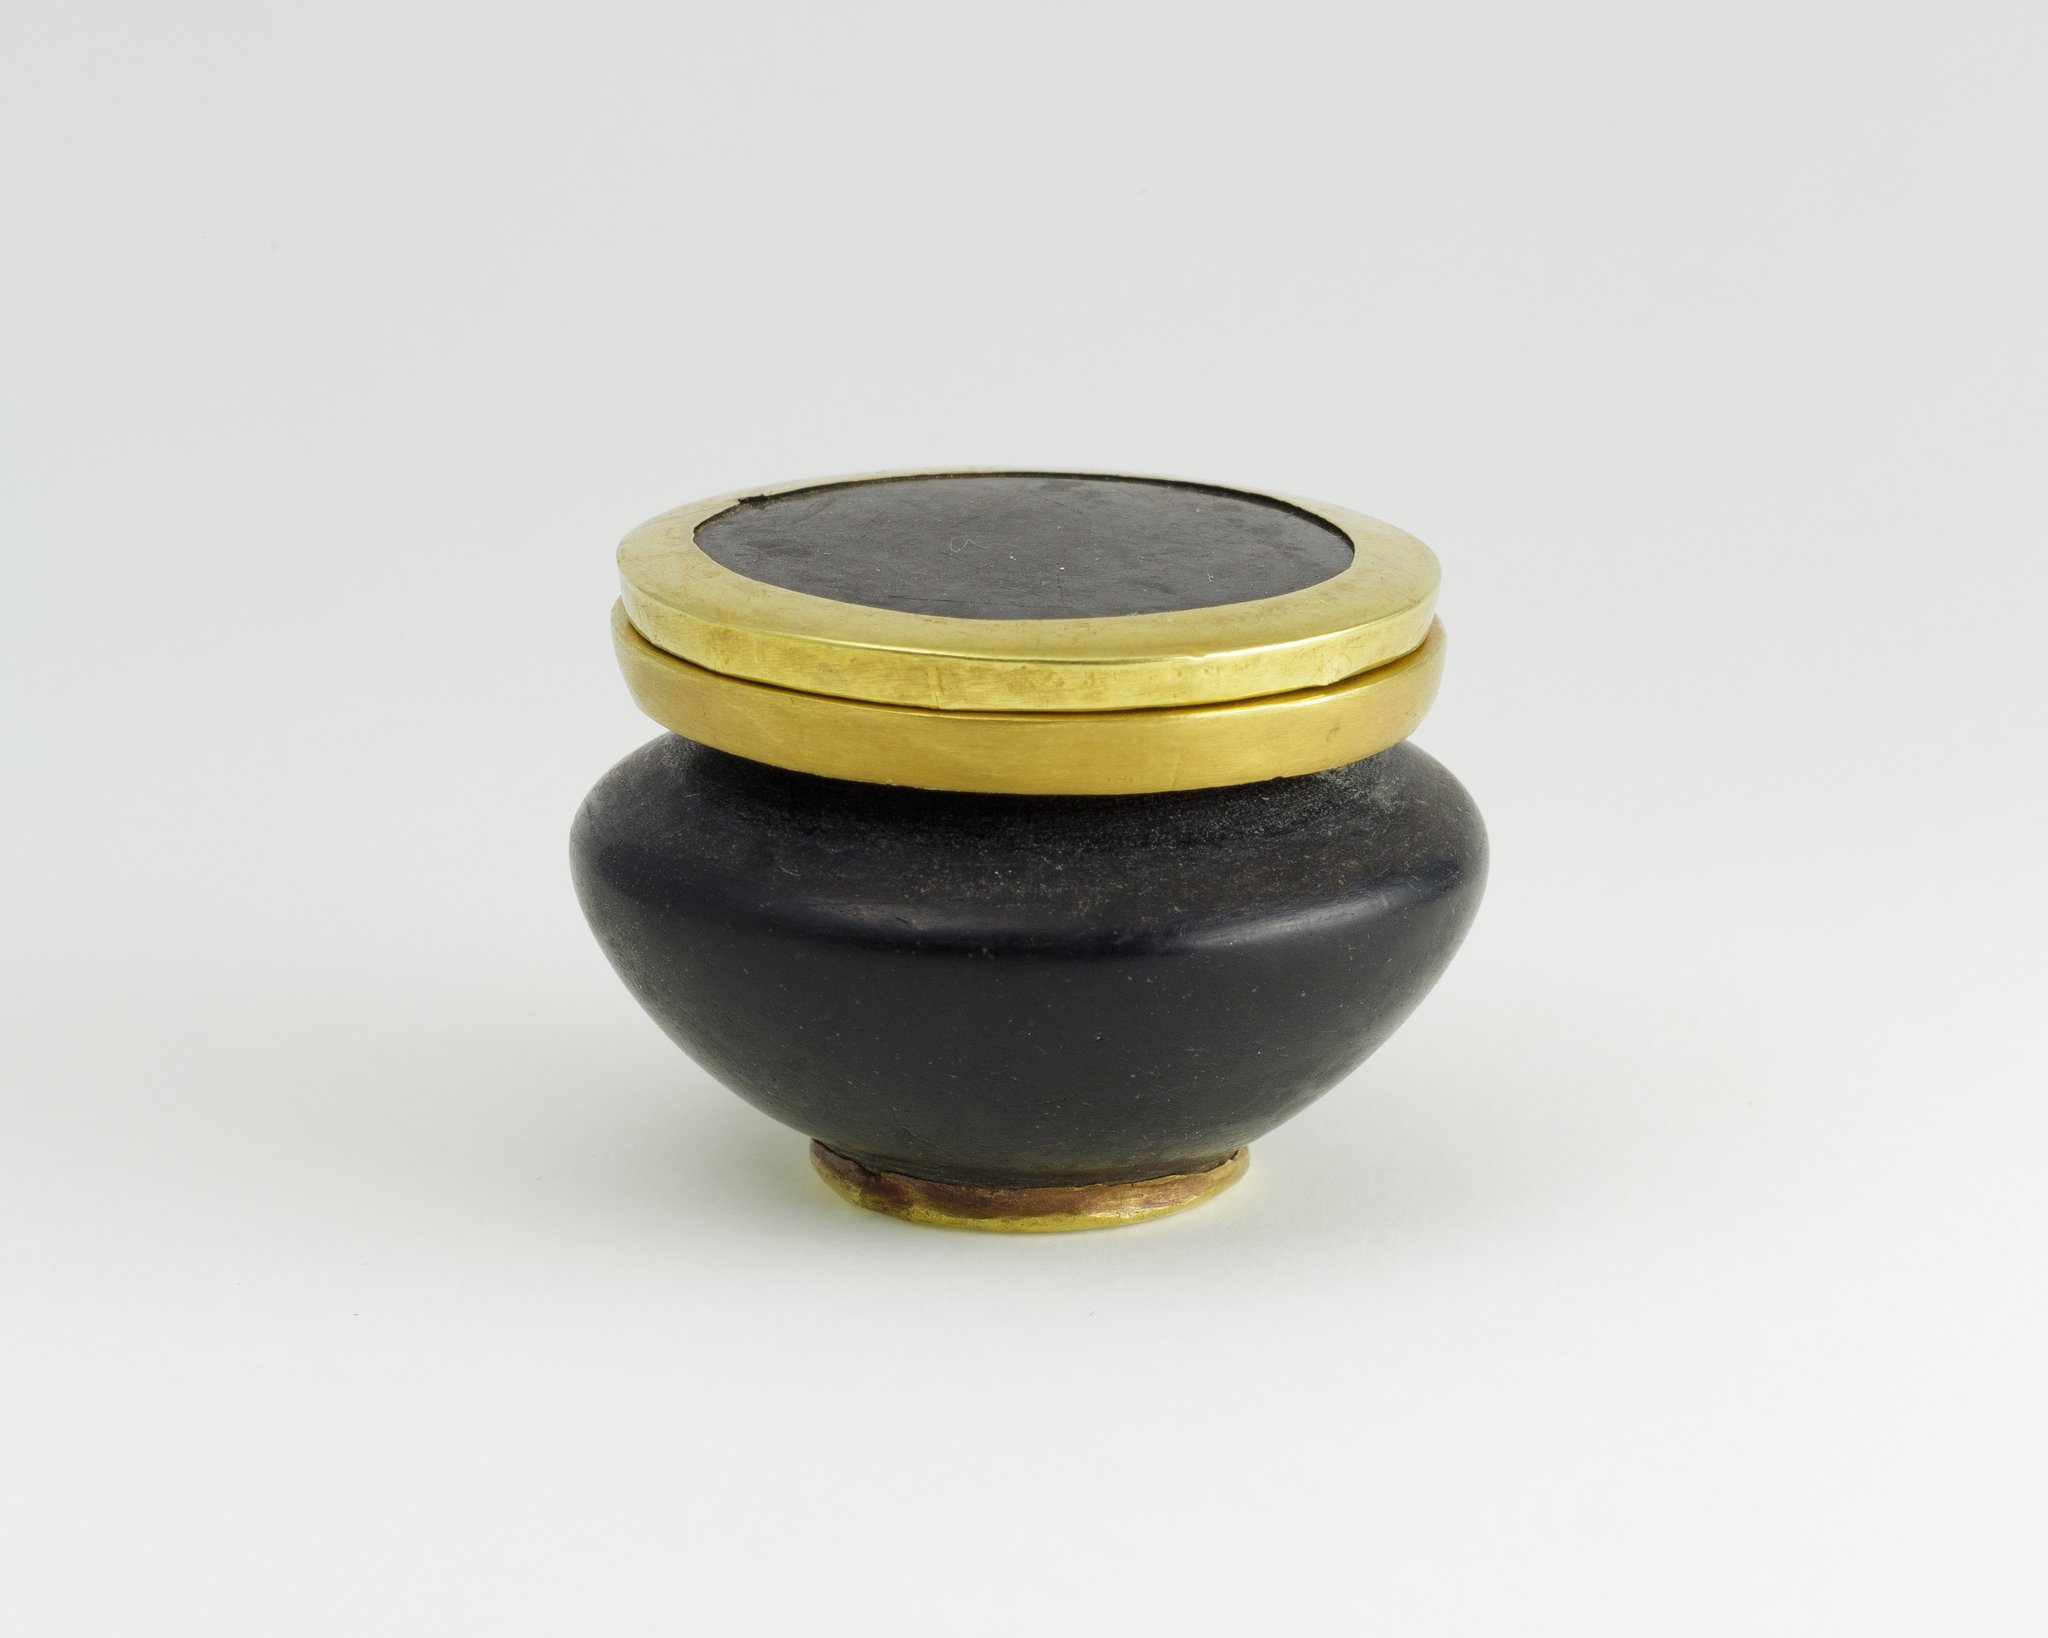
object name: kohl jar, sithathoryunet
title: Kohl Jar of Sithathoryunet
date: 1887-1813 BCE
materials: gold, obsidian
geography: egypt